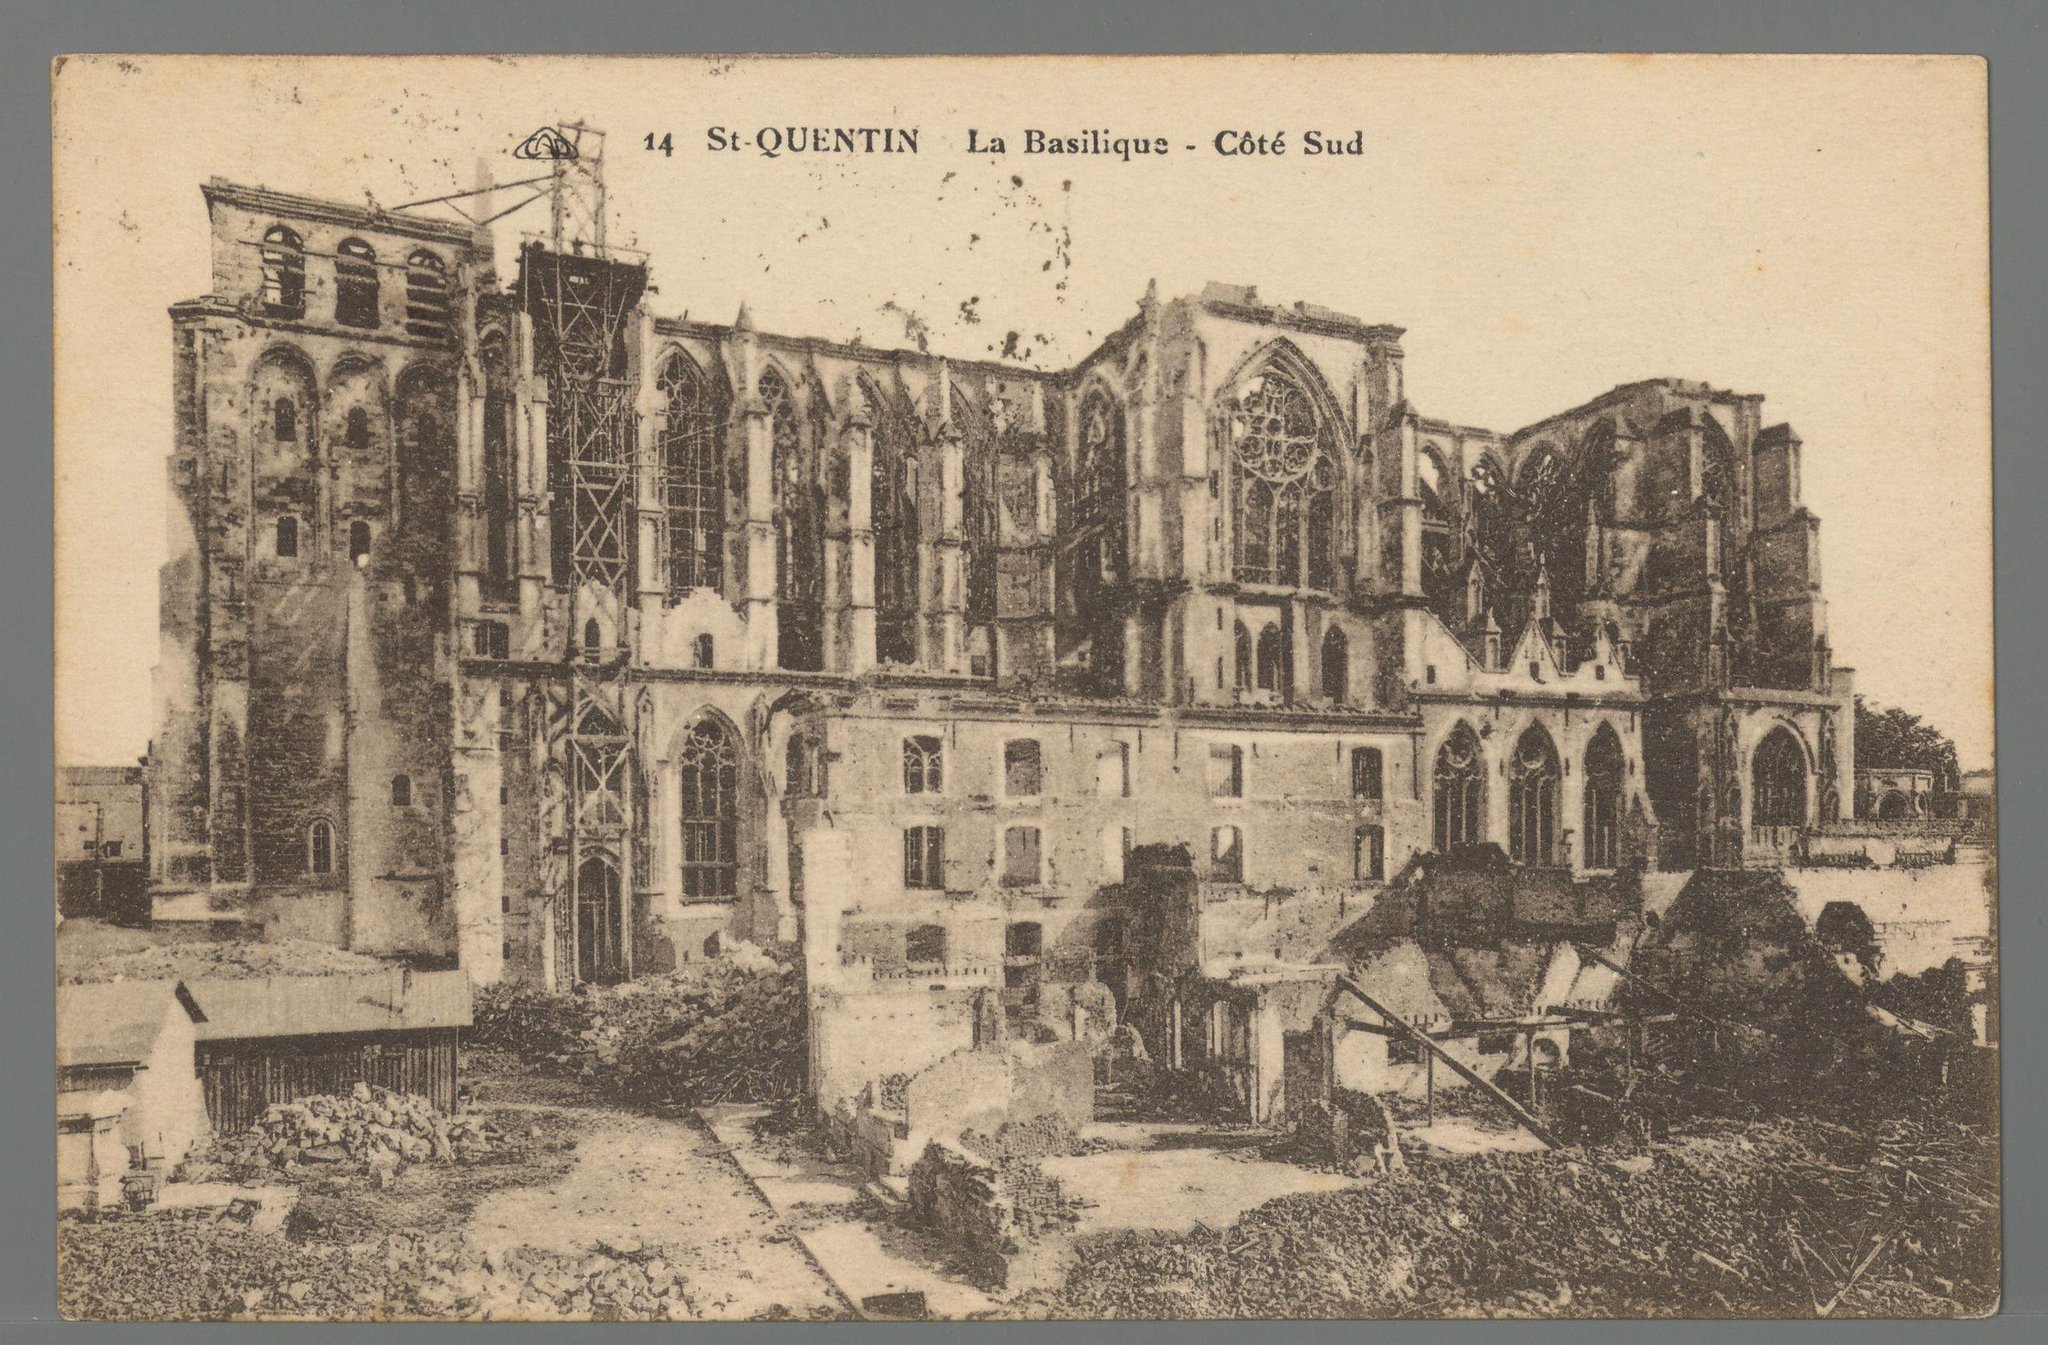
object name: ansichtkaart, prentbriefkaart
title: St. Quentin La Basilique Côté Sud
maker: Anonymous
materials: cardboard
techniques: photograph, writing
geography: straatsburg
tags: church (exterior)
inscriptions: postage stamp